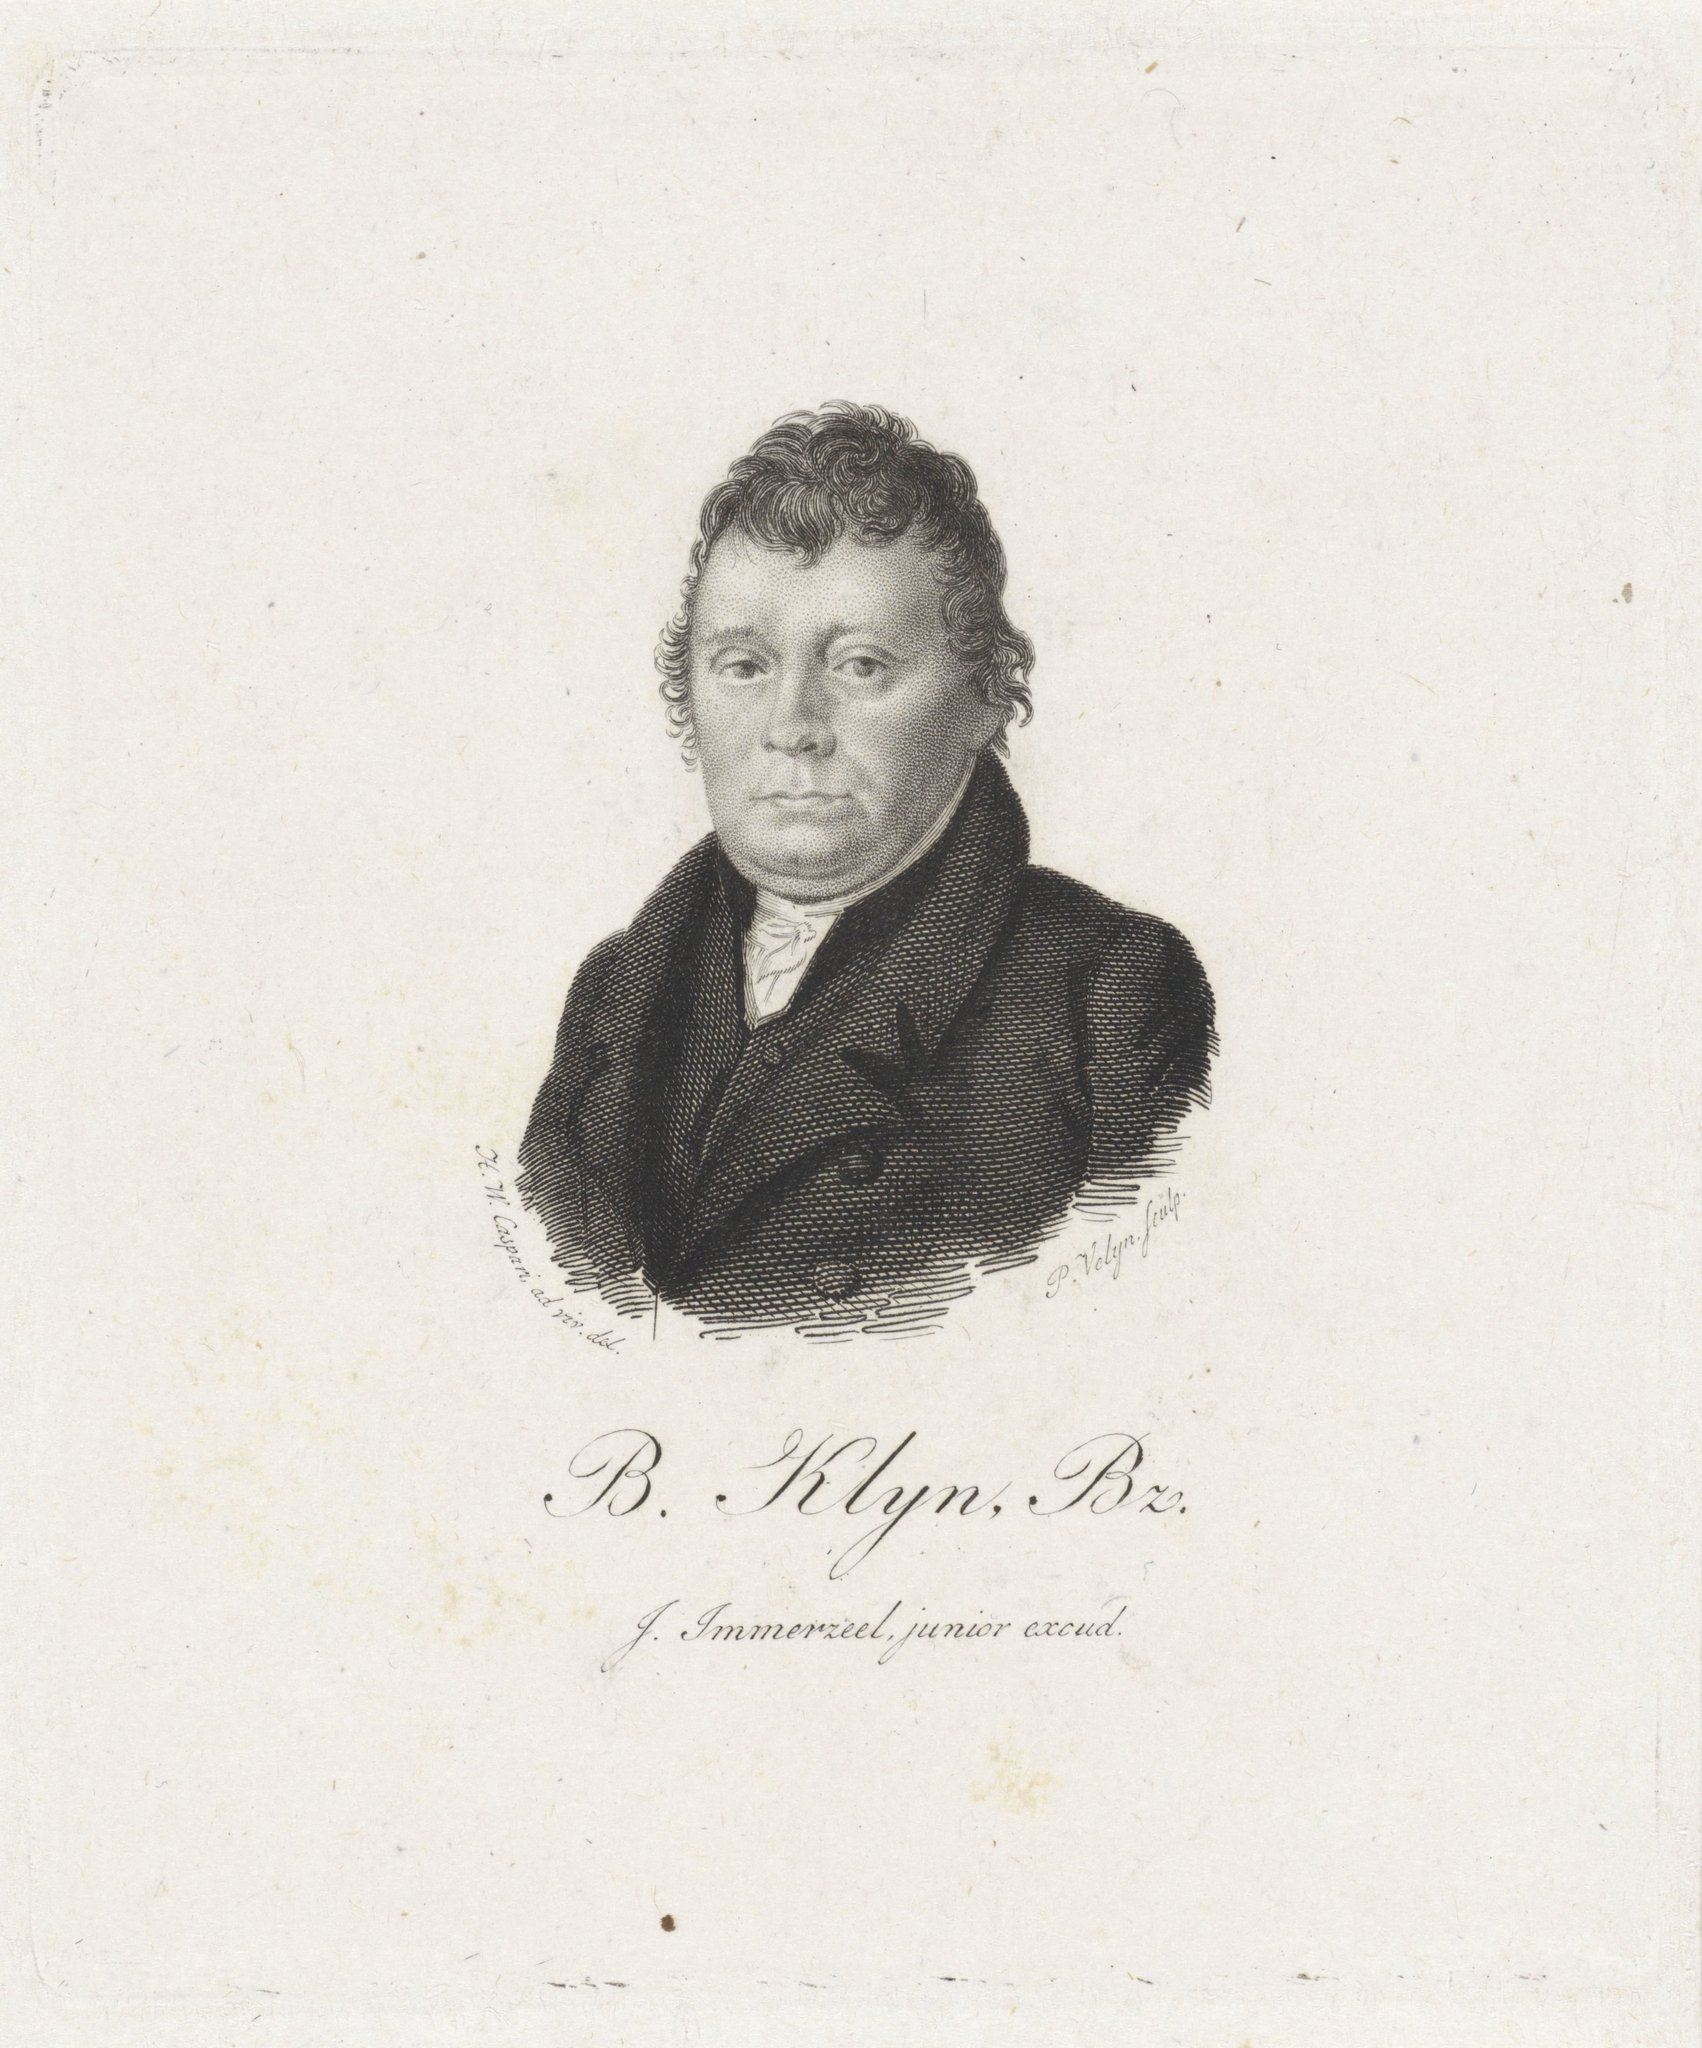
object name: print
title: Portret van Barend Klijn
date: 1797-1836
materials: paper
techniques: engraving, etching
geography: netherlands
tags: amsterdam, barend klijn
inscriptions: collector's mark: Lugt 2228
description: Portret van Barend Klijn, suikerraffinadeur en dichter in Amsterdam.